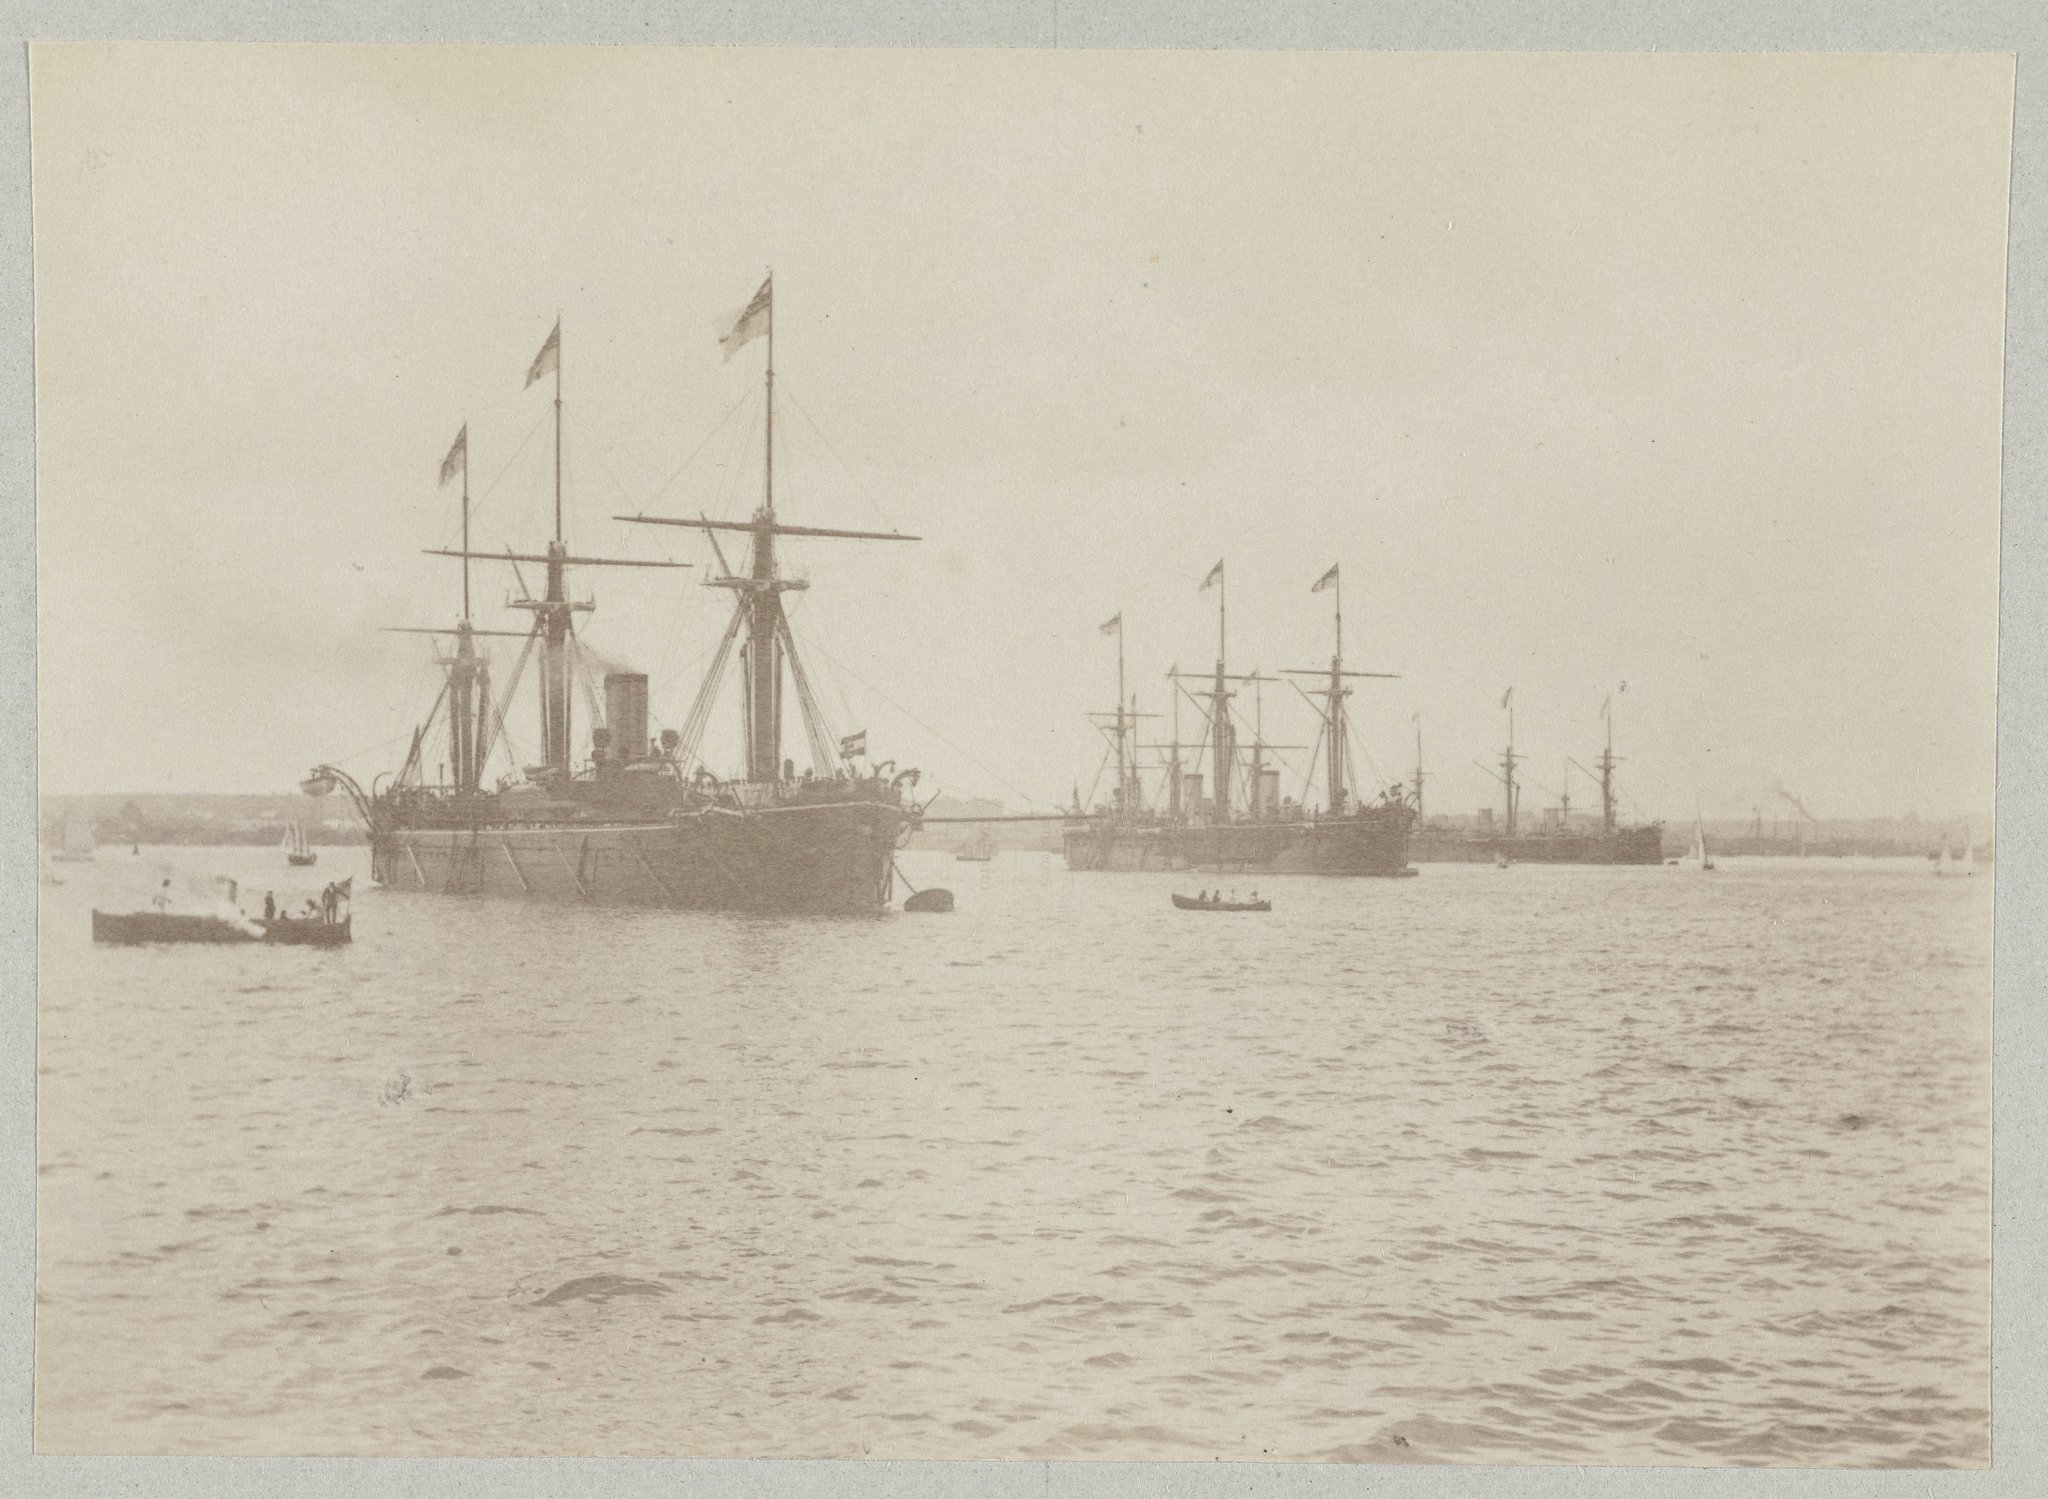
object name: photograph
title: Stoomschepen op zee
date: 1807-1889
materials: cardboard, paper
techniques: albumen print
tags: wilhelm ii (keizer van duitsland), norway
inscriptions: number: ‘1a’